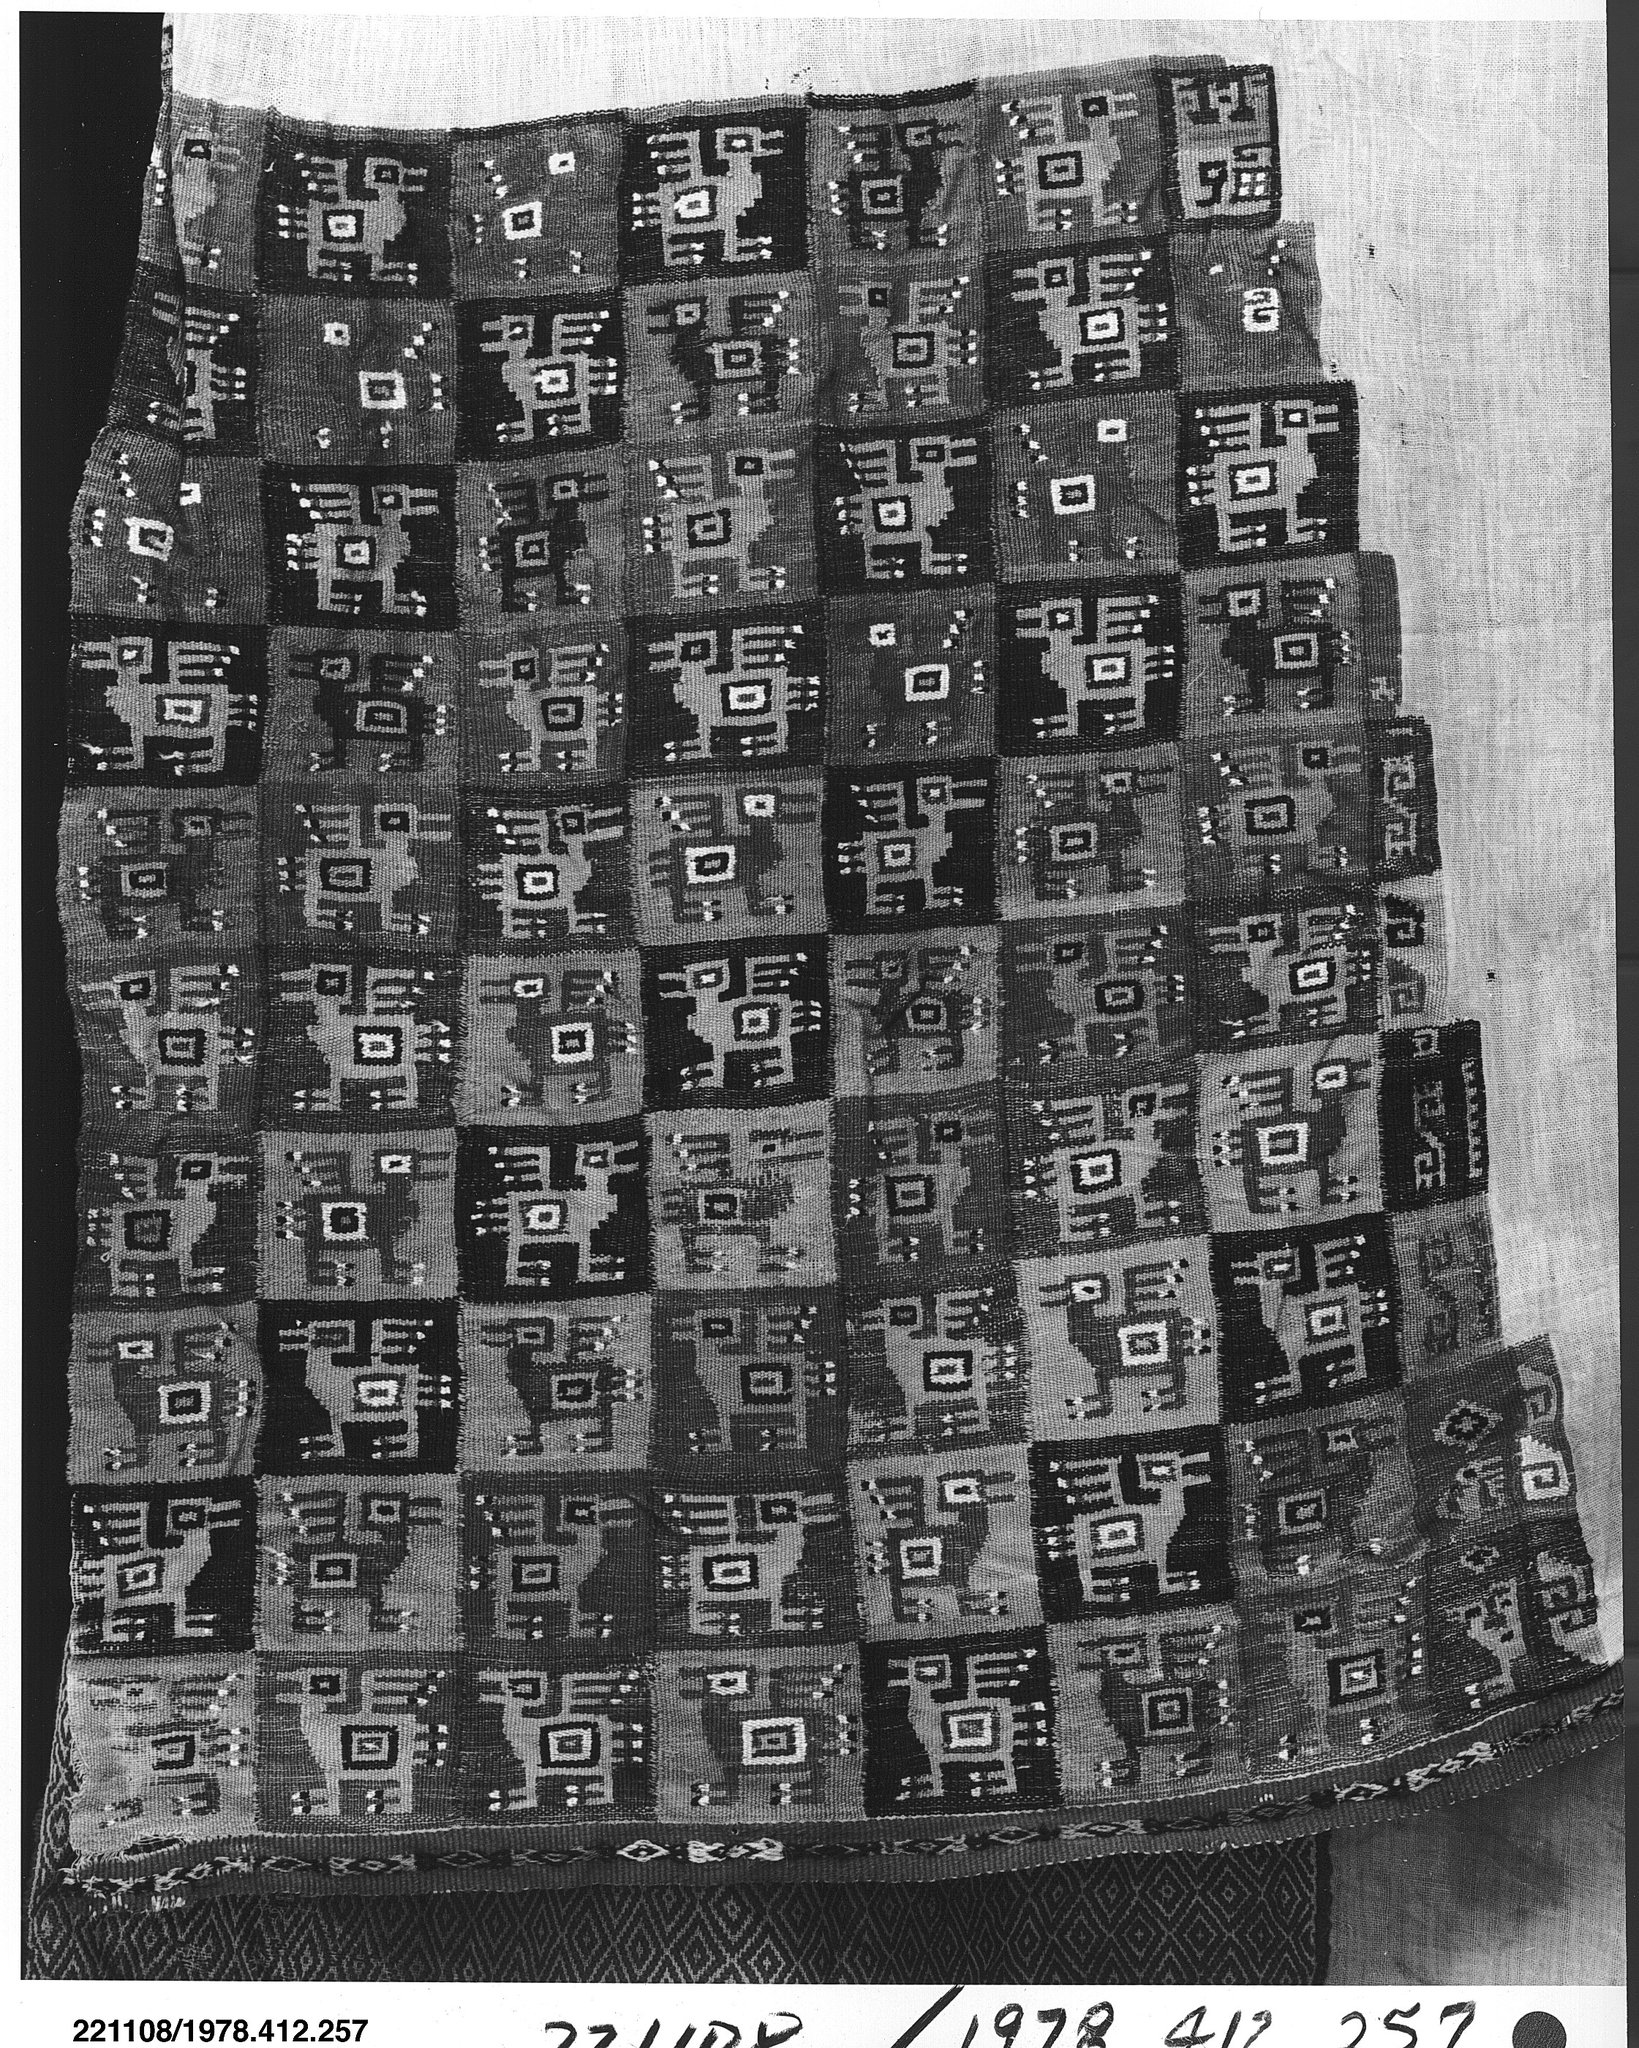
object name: mantle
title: Mantle Fragment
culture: wari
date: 801-1000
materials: animal fiber, cotton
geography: peru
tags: birds